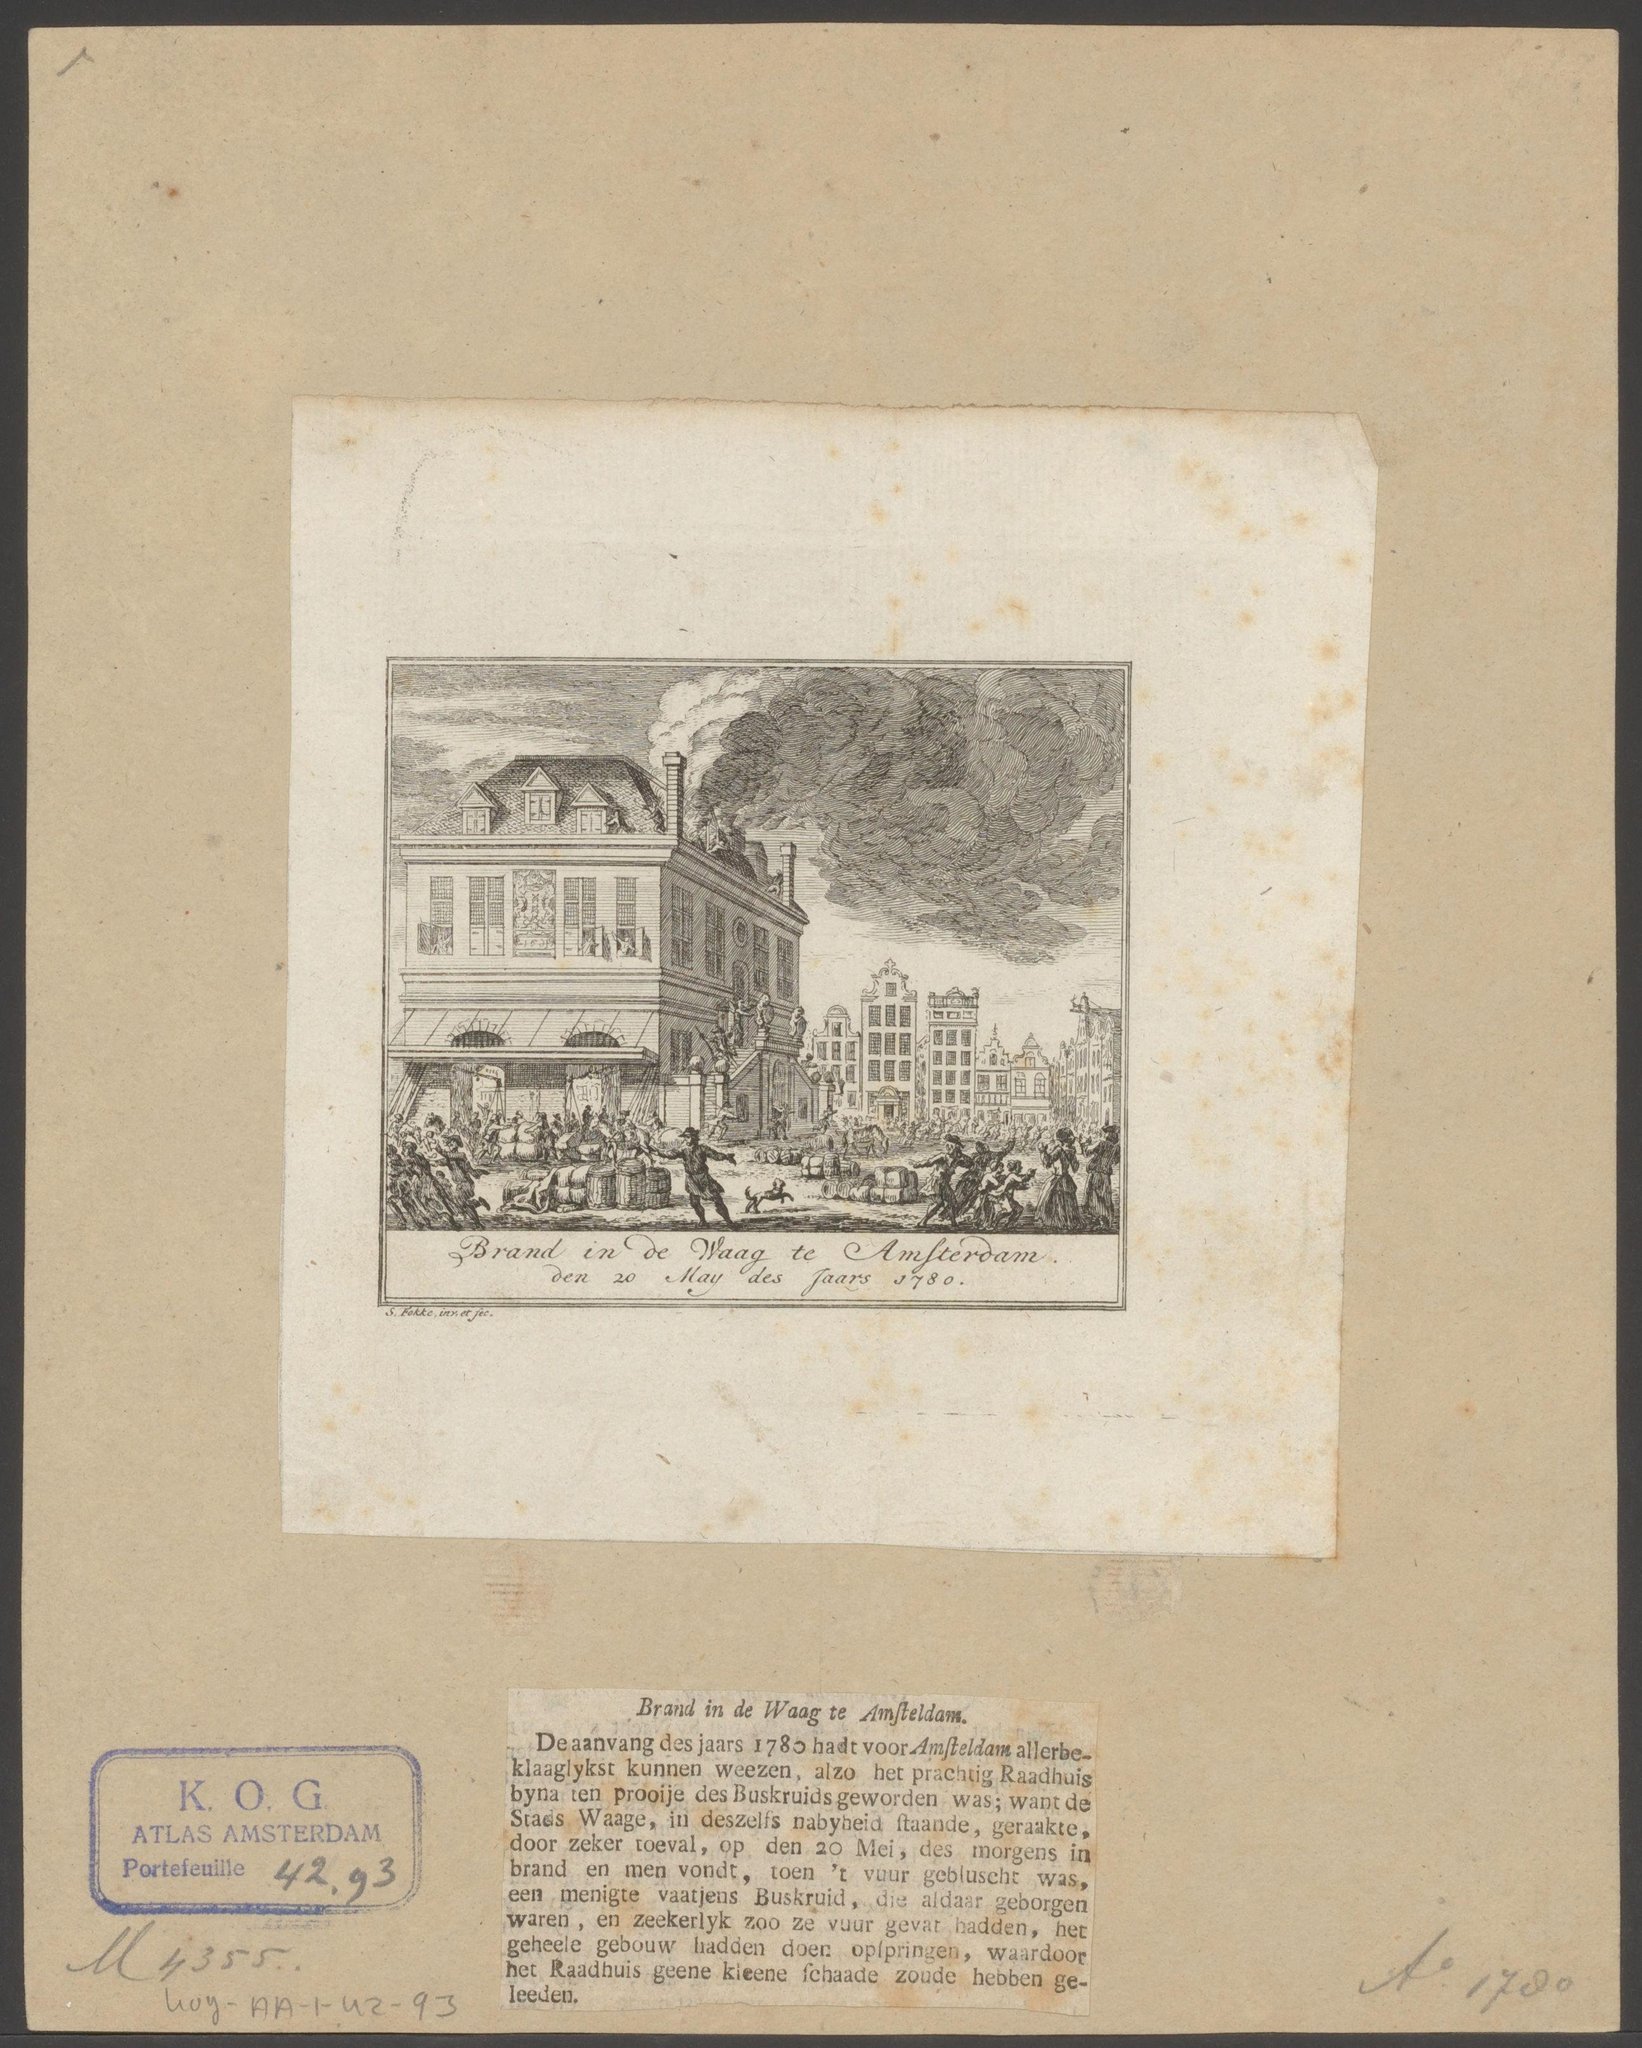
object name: print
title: Brand in de Waag te Amsterdam den 20 May des Jaars 1780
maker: simon fokke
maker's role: draughtsman, print maker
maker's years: 1712-1784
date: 1781-1793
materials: paper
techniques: etching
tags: weigh-house, square, place, circus, etc. (+ city(-scape) with figures, staffage), amsterdam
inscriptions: collector's mark: Lugt 1461b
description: Prent met vermelding van de uitgever gebruikt in: De nieuwe vaderlandsche Almanach voor den Jaare 1781. Amsterdam: Arend Fokke, 1782. De vaderlandsche historie in themata (...). Amsterdam: Arend Fokke, 1783. En in: De vaderlandsche historie in themata (...). 2de druk. Amsterdam: Arend Fokke, 1788.